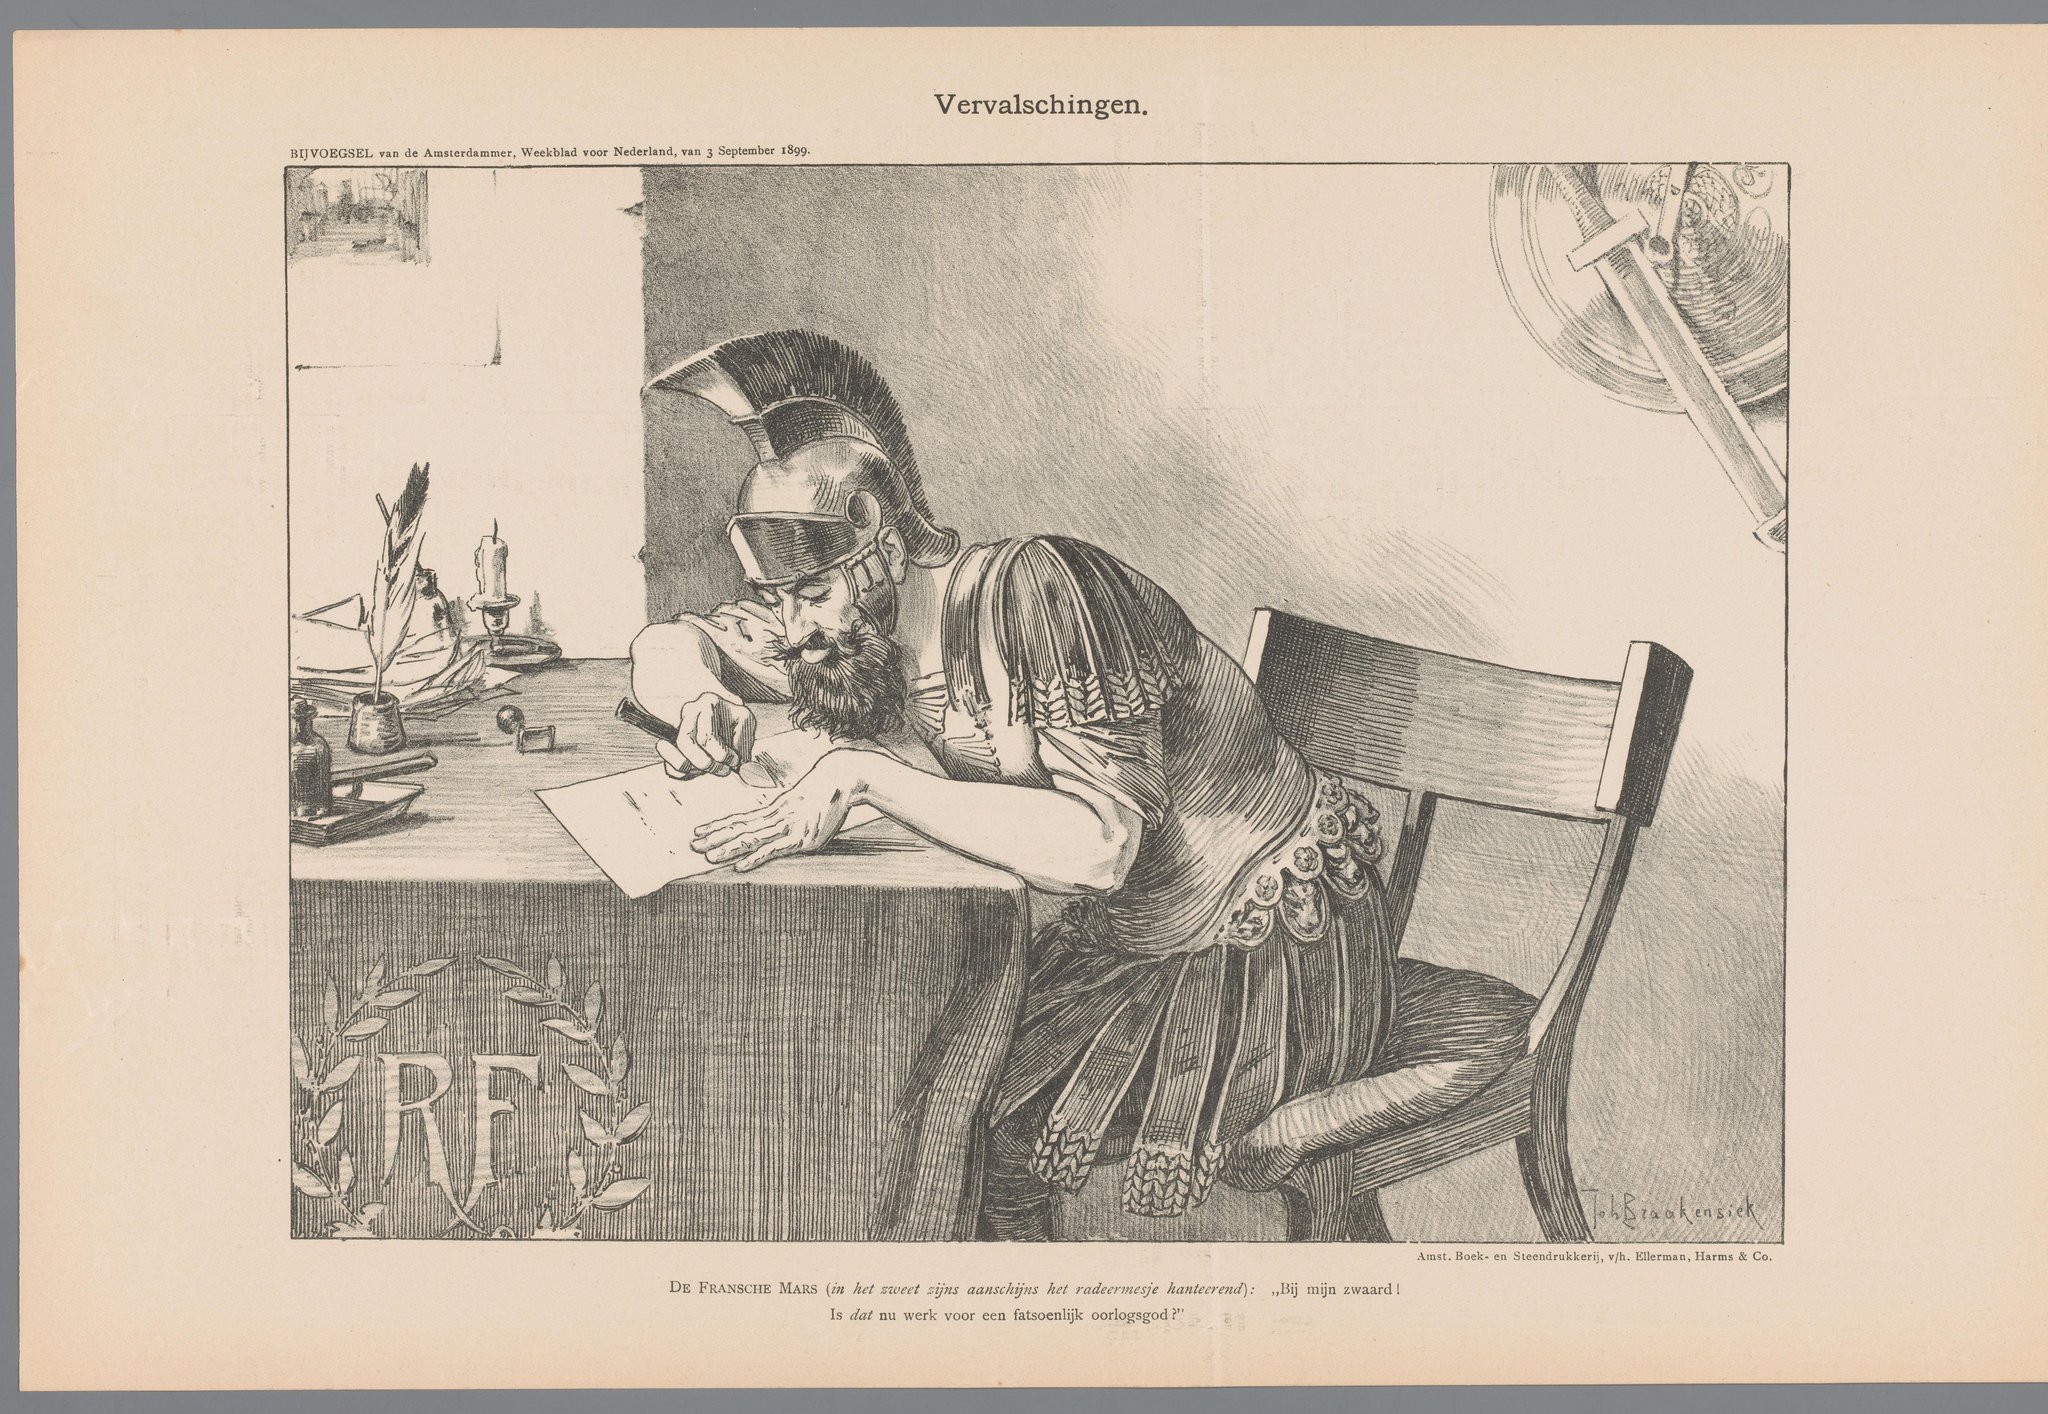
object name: cartoon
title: Vervalschingen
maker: johan braakensiek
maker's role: draughtsman, print maker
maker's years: 1858-1940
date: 1899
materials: paper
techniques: lithograph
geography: amsterdam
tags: (story of) mars (ares), counterfeit, forgery, political caricatures and satires, france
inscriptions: date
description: Prent uit het bijvoegsel van: De Amsterdammer. Weekblad voor Nederland, 3 september 1899.